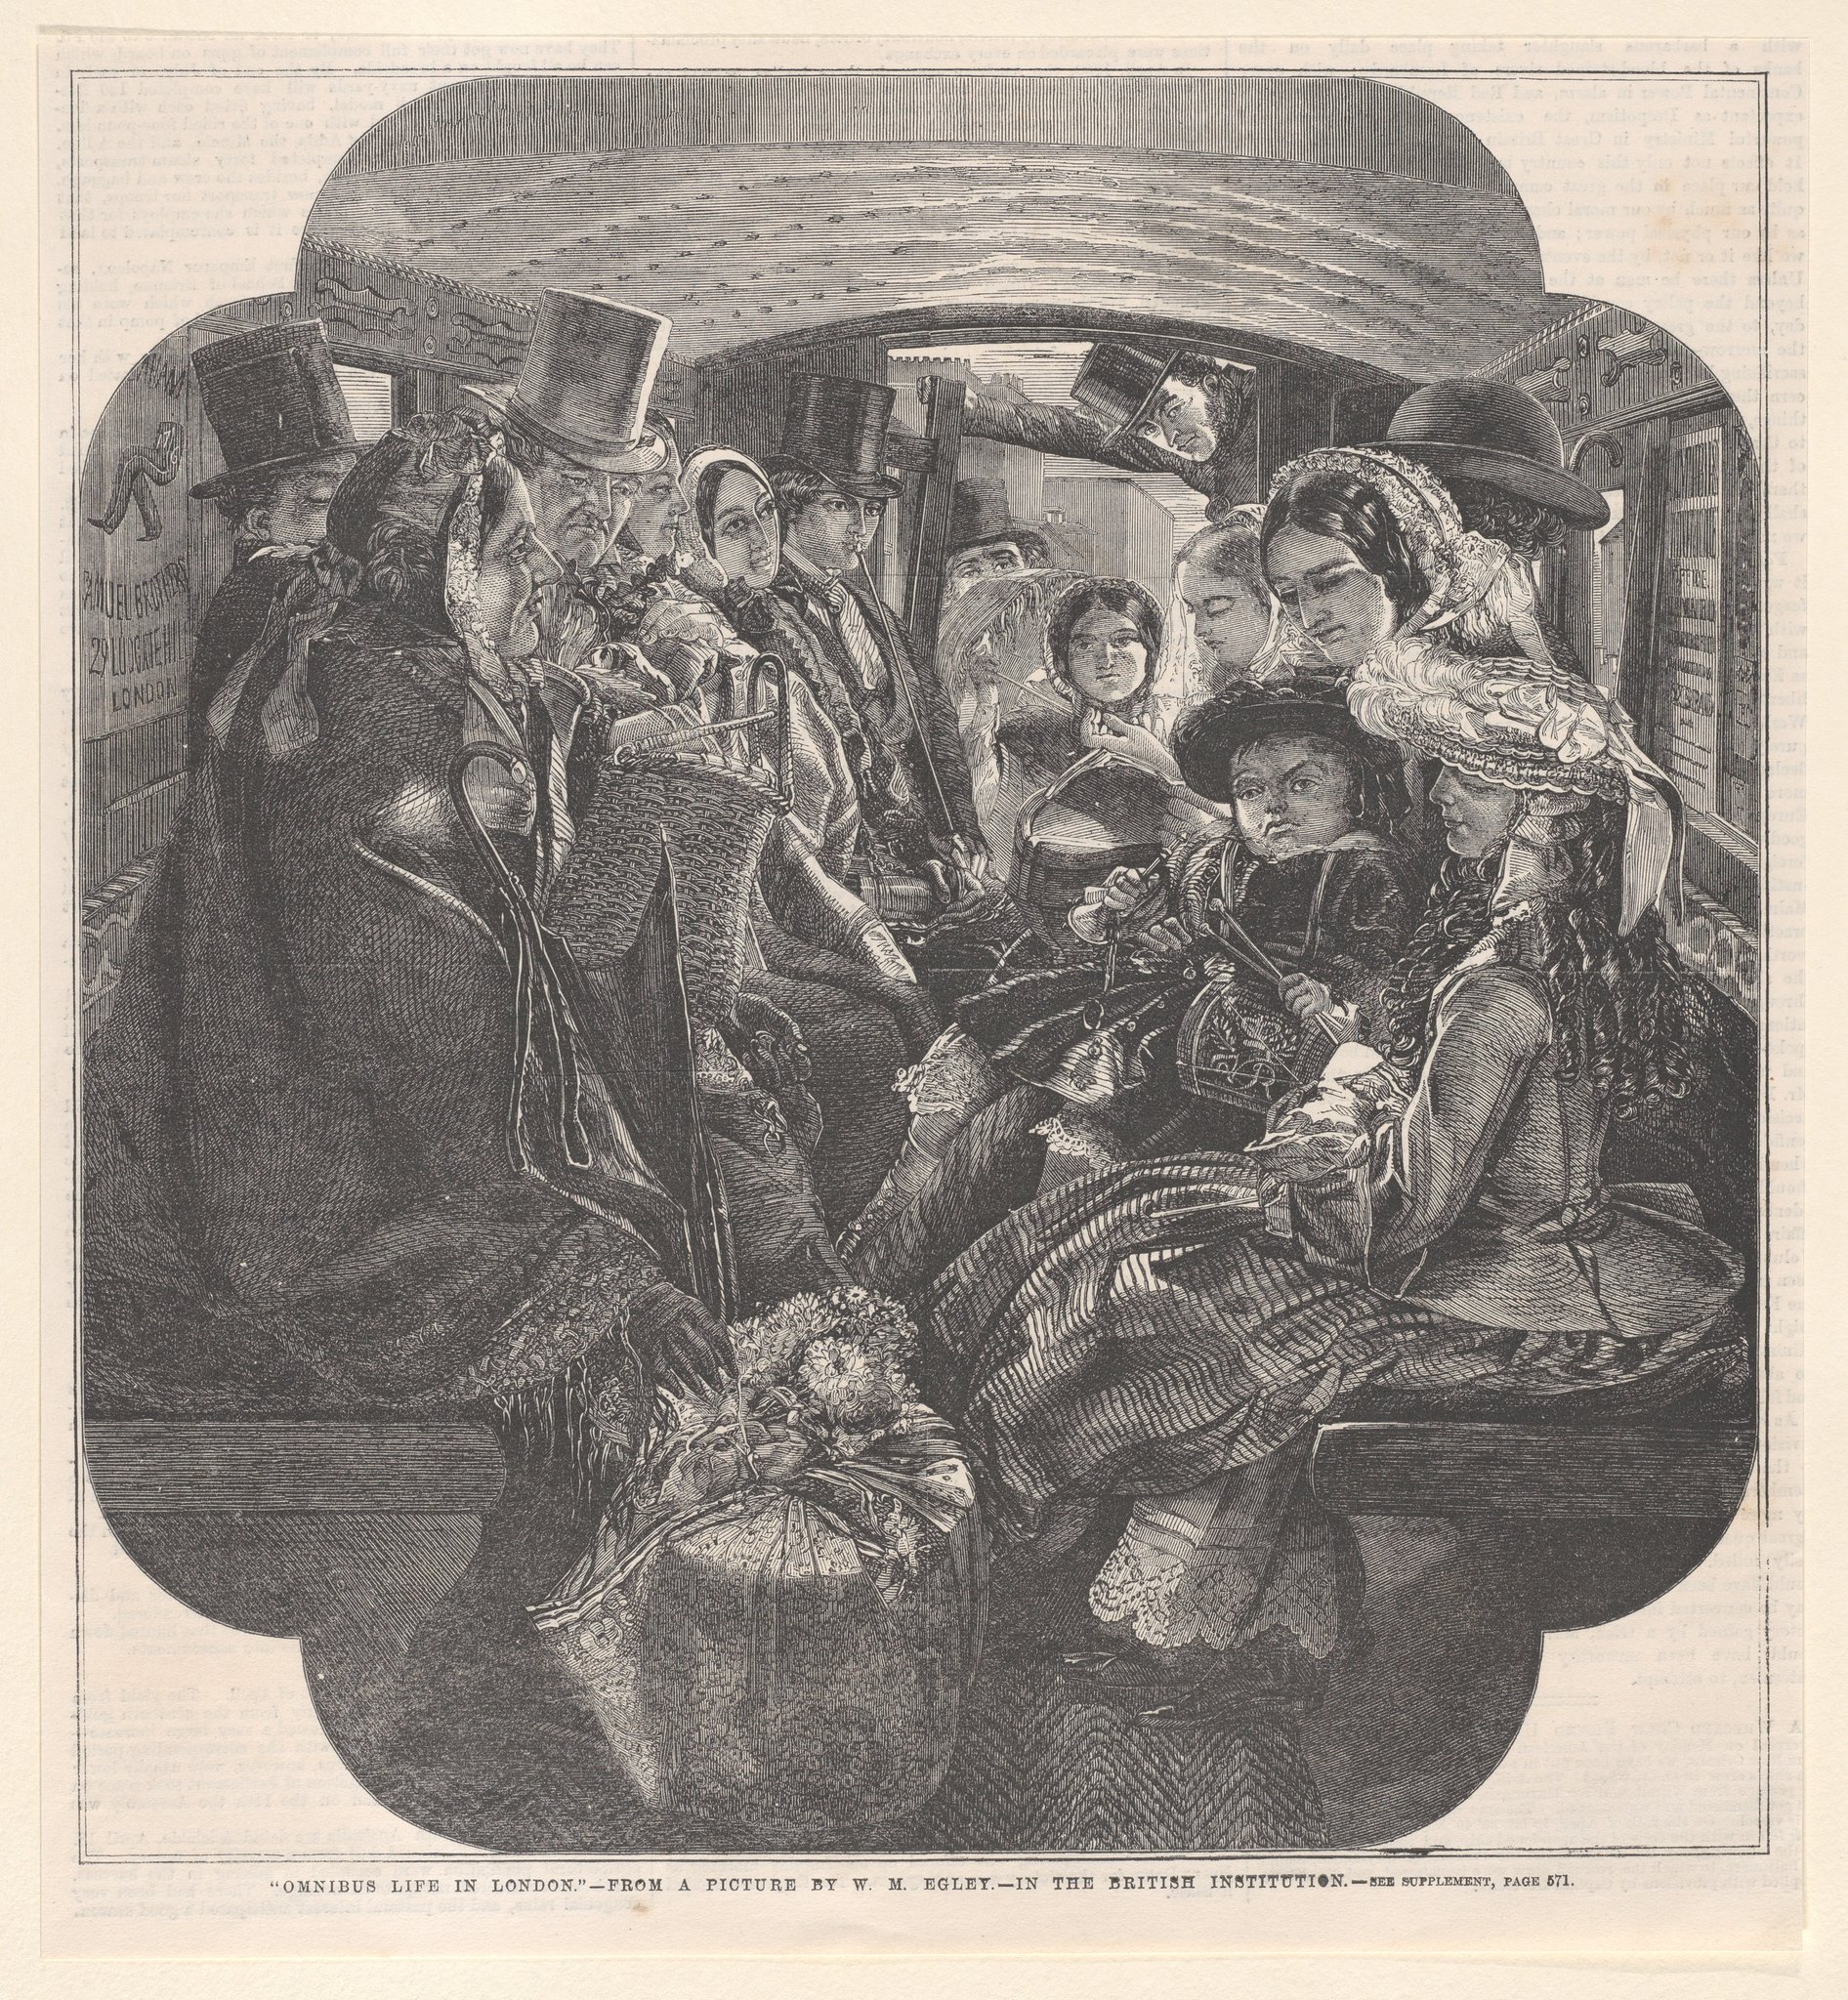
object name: print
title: Omnibus Life in London, from "Illustrated London News"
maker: william maw egley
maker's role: artist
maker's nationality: british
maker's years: 1826-1916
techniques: engraving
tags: children,men,women,transportation